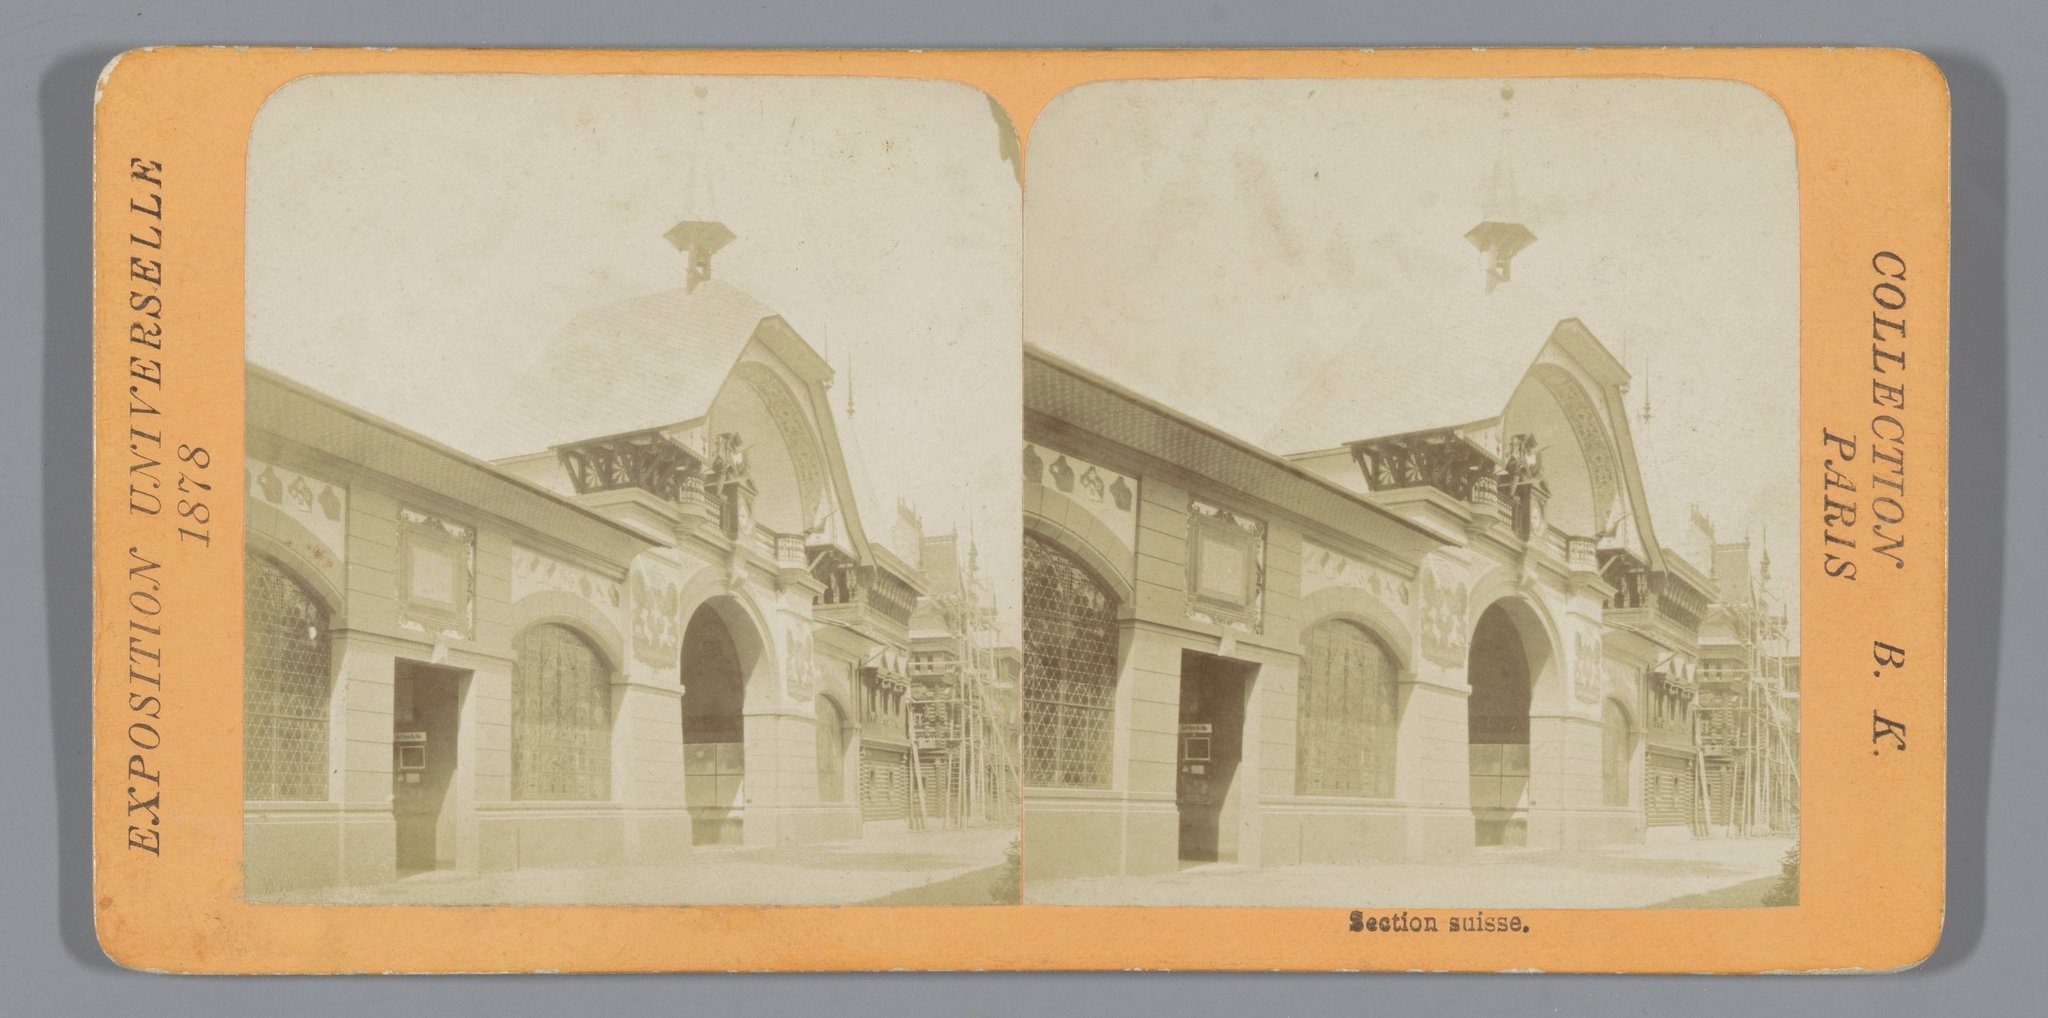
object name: stereograph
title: Exposition Universelle 1878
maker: adolphe block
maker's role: publisher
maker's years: 1829-1918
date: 1878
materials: cardboard, paper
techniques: albumen print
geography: paris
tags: world fair, world exhibition, exterior ~ representation of a building, paris